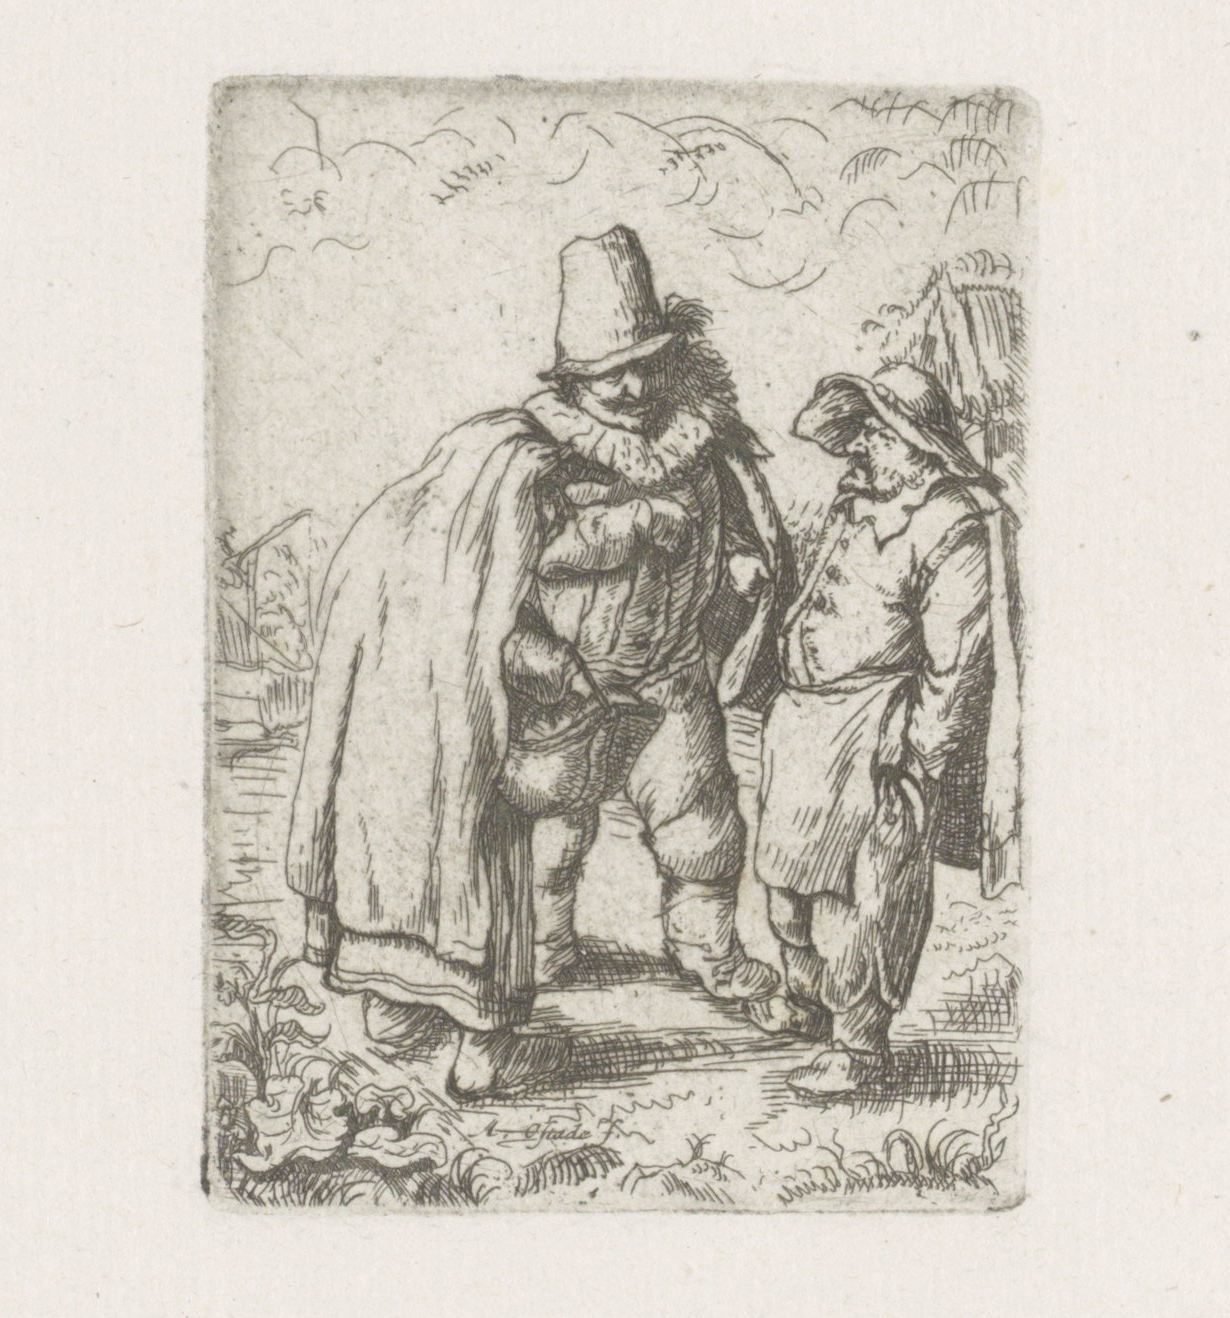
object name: print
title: Man met plooikraag bij een boerenpaar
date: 1846-1900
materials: paper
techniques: etching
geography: haarlem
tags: quack, charlatan, mountebank, 'saltimbanco', farmers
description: De man met de plooikraag is mogelijk een kwakzalver. De vrouw draagt een huik. Deze prent maakt deel uit van een album.